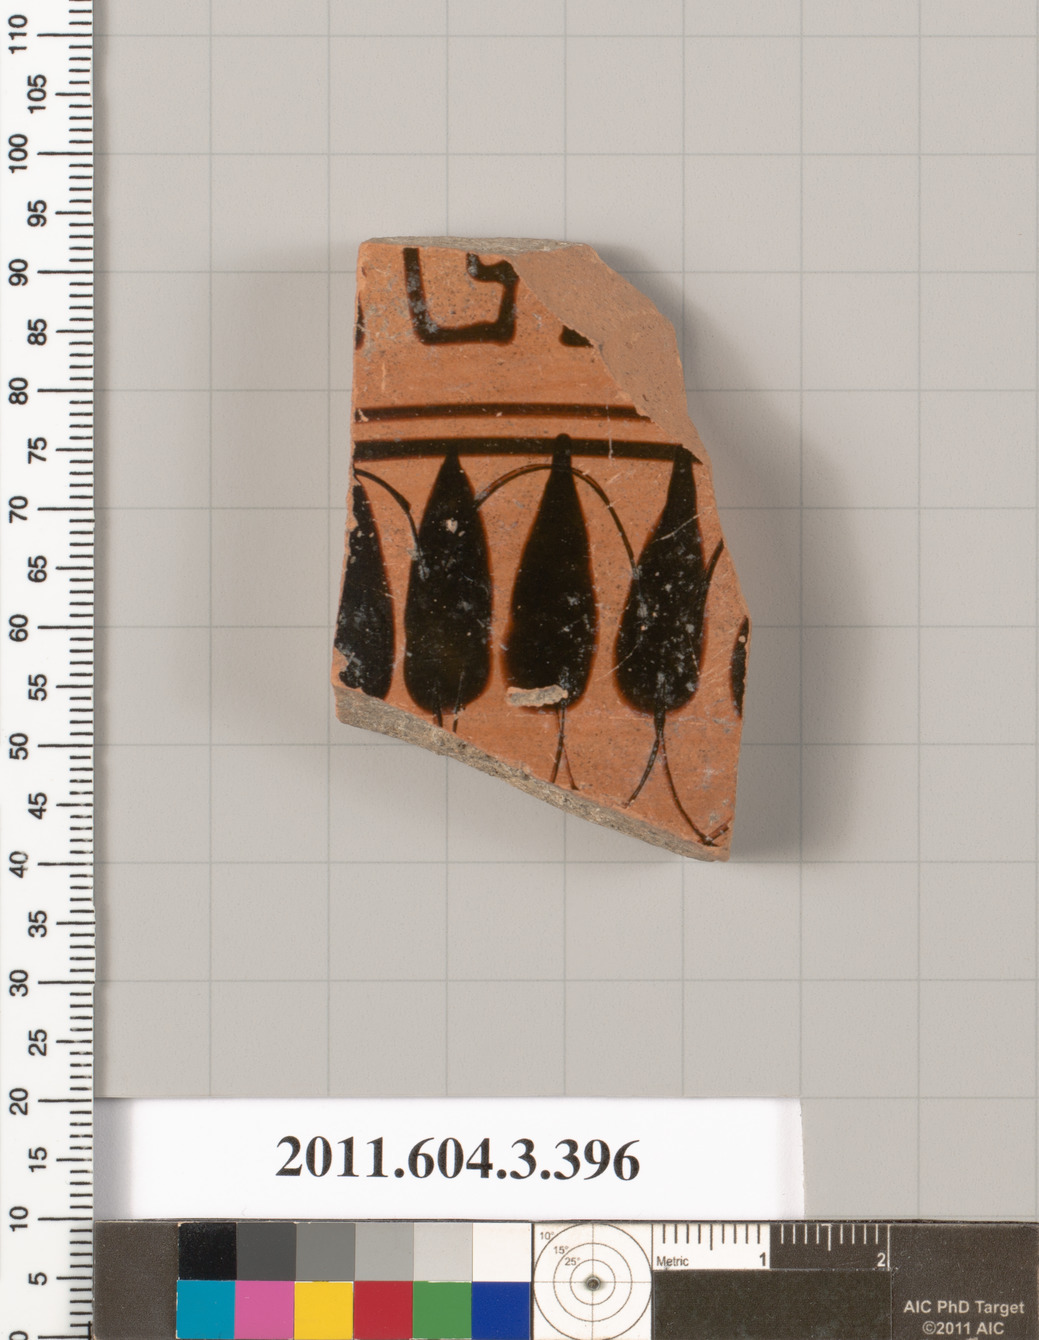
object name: neck amphora fragment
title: Terracotta fragment of a neck-amphora (jar)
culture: greek, attic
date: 520 BCE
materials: terracotta